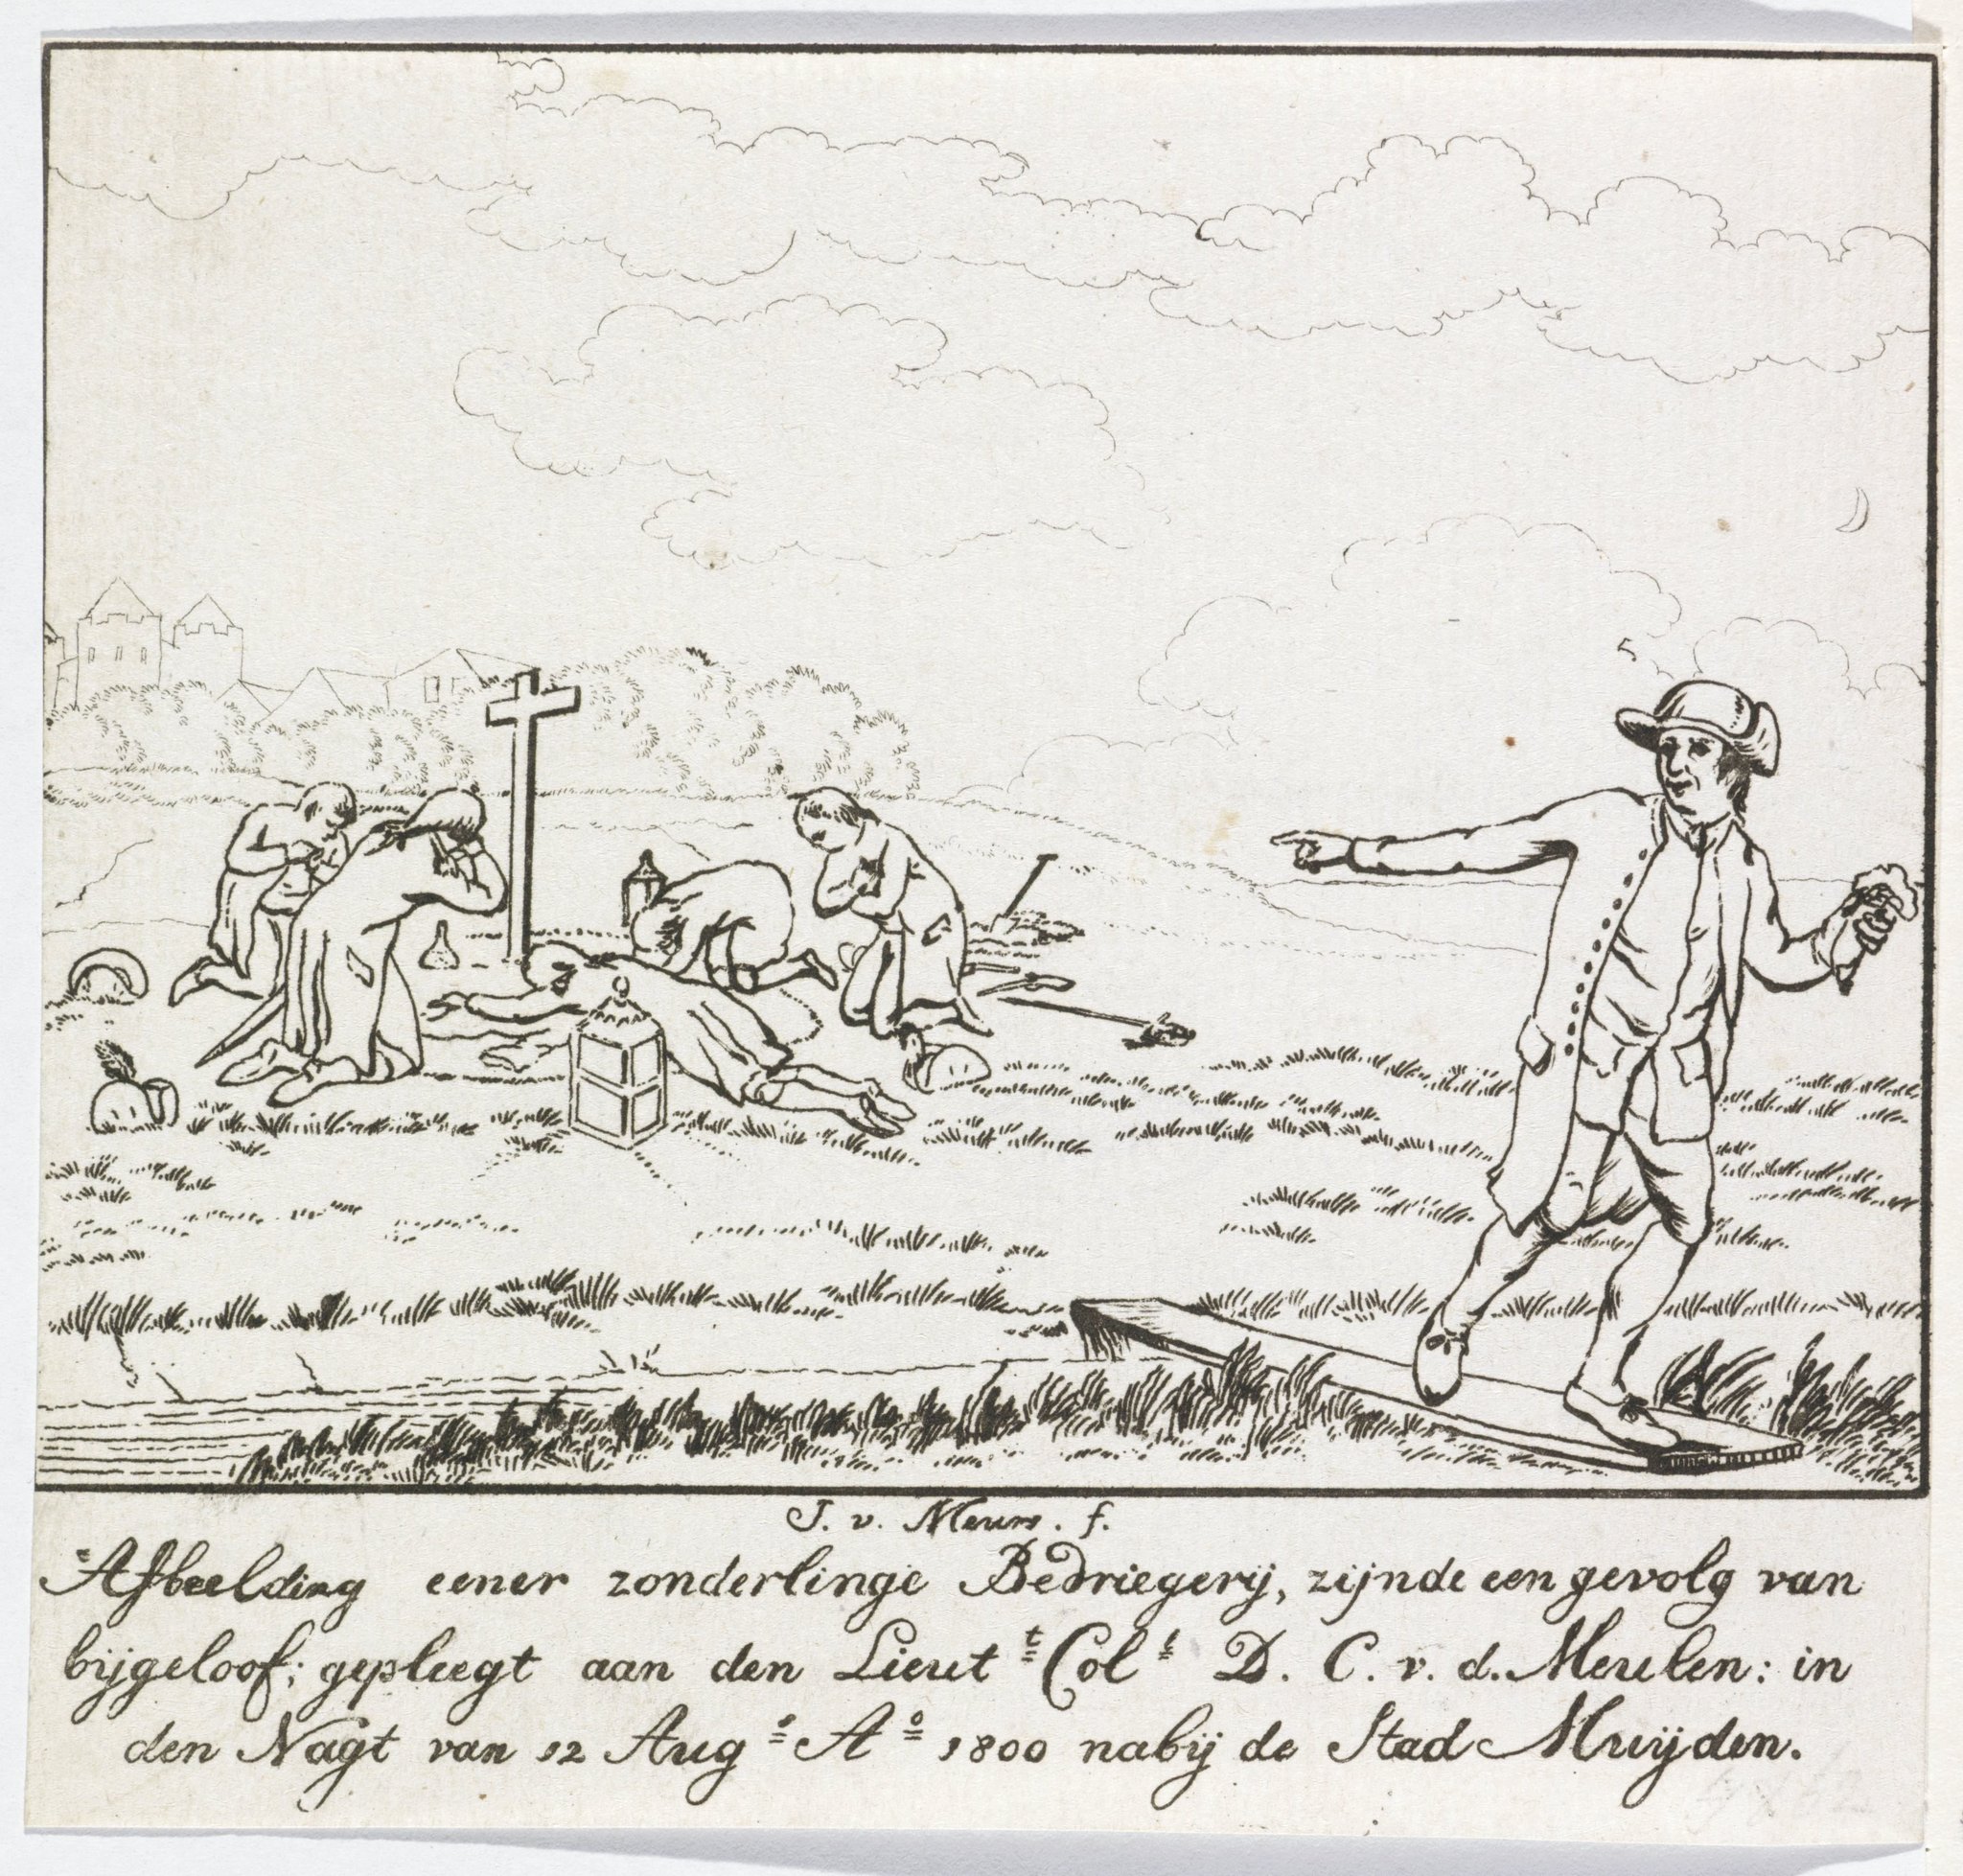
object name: print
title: Afbeelding eener zonderlinge Bedriegerij (...) gepleegt aan den Lieut. Col. D.C. v.d. Meulen (...)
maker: jacobus van meurs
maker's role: draughtsman, painter, print maker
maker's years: 1760-1824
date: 1800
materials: paper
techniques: etching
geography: netherlands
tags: digging for or finding of treasure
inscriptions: collector's mark: Lugt 2228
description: De schatzoekers van Muiden bidden rond het kruis op de plaats van de vermeende schat. De Duitse oplichter gaat er lachend wijzend vandoor met de zak geld. Illustratie van het verhaal van het bedrog van de bijgelovige katholieke luitenant-kolonel Dirk Cornelis van der Meulen door een Duitse oplichter, te Muiden in de nacht van 12 op 13 augustus 1800. Op de achtergrond het Muiderslot. Op het blad onder de plaat een vers in twee kolommen.